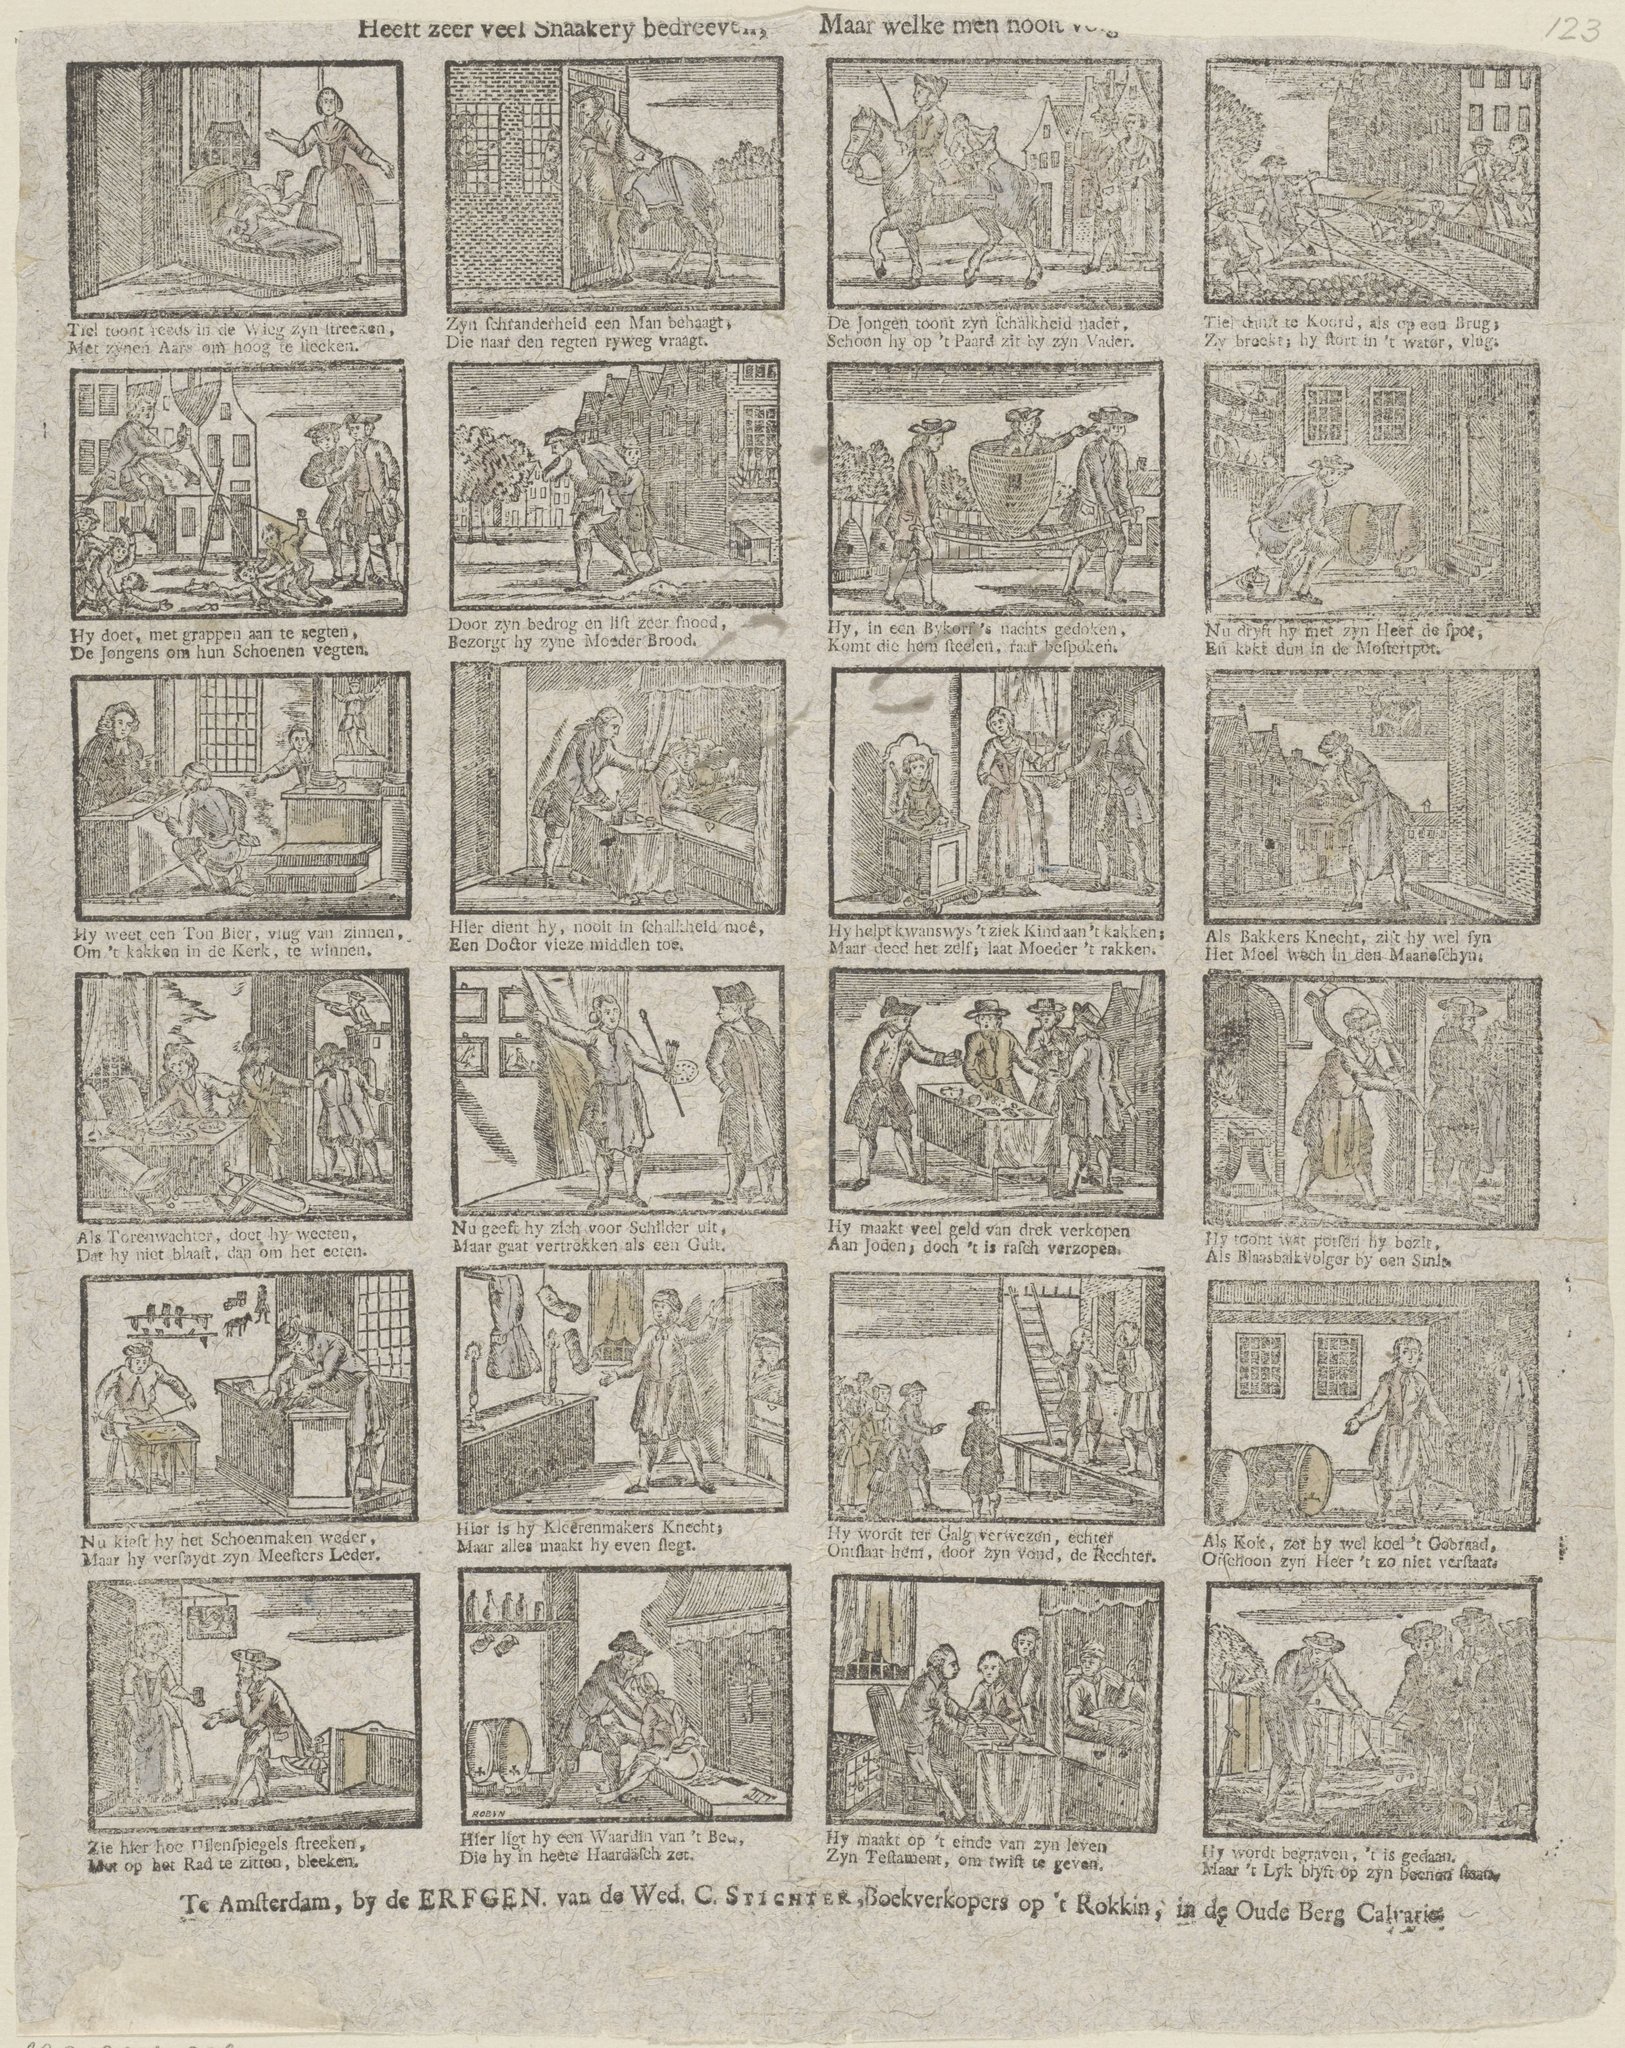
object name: print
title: [Tiel uilenspiegel, in zyn leven,] / Heeft zeer veel snaakery bedreeven, / [Die dikwijls iemand lagchen doet;]/ Maar welke men nooit [volgen moet]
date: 1715-1813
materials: paper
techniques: colour, letterpress printing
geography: amsterdam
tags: eulenspiegel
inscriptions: collector's mark: Lugt 2760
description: Blad met 24 voorstellingen over het leven van Tijl Uilenspiegel. Onder elke afbeelding een tweeregelig vers. Bovenkant afgescheurd, normaal rechtsboven genummerd: No. 123.